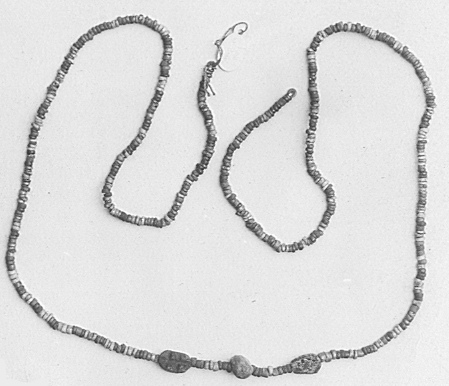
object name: bead, string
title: String of beads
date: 2040-1458 BCE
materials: faience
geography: egypt